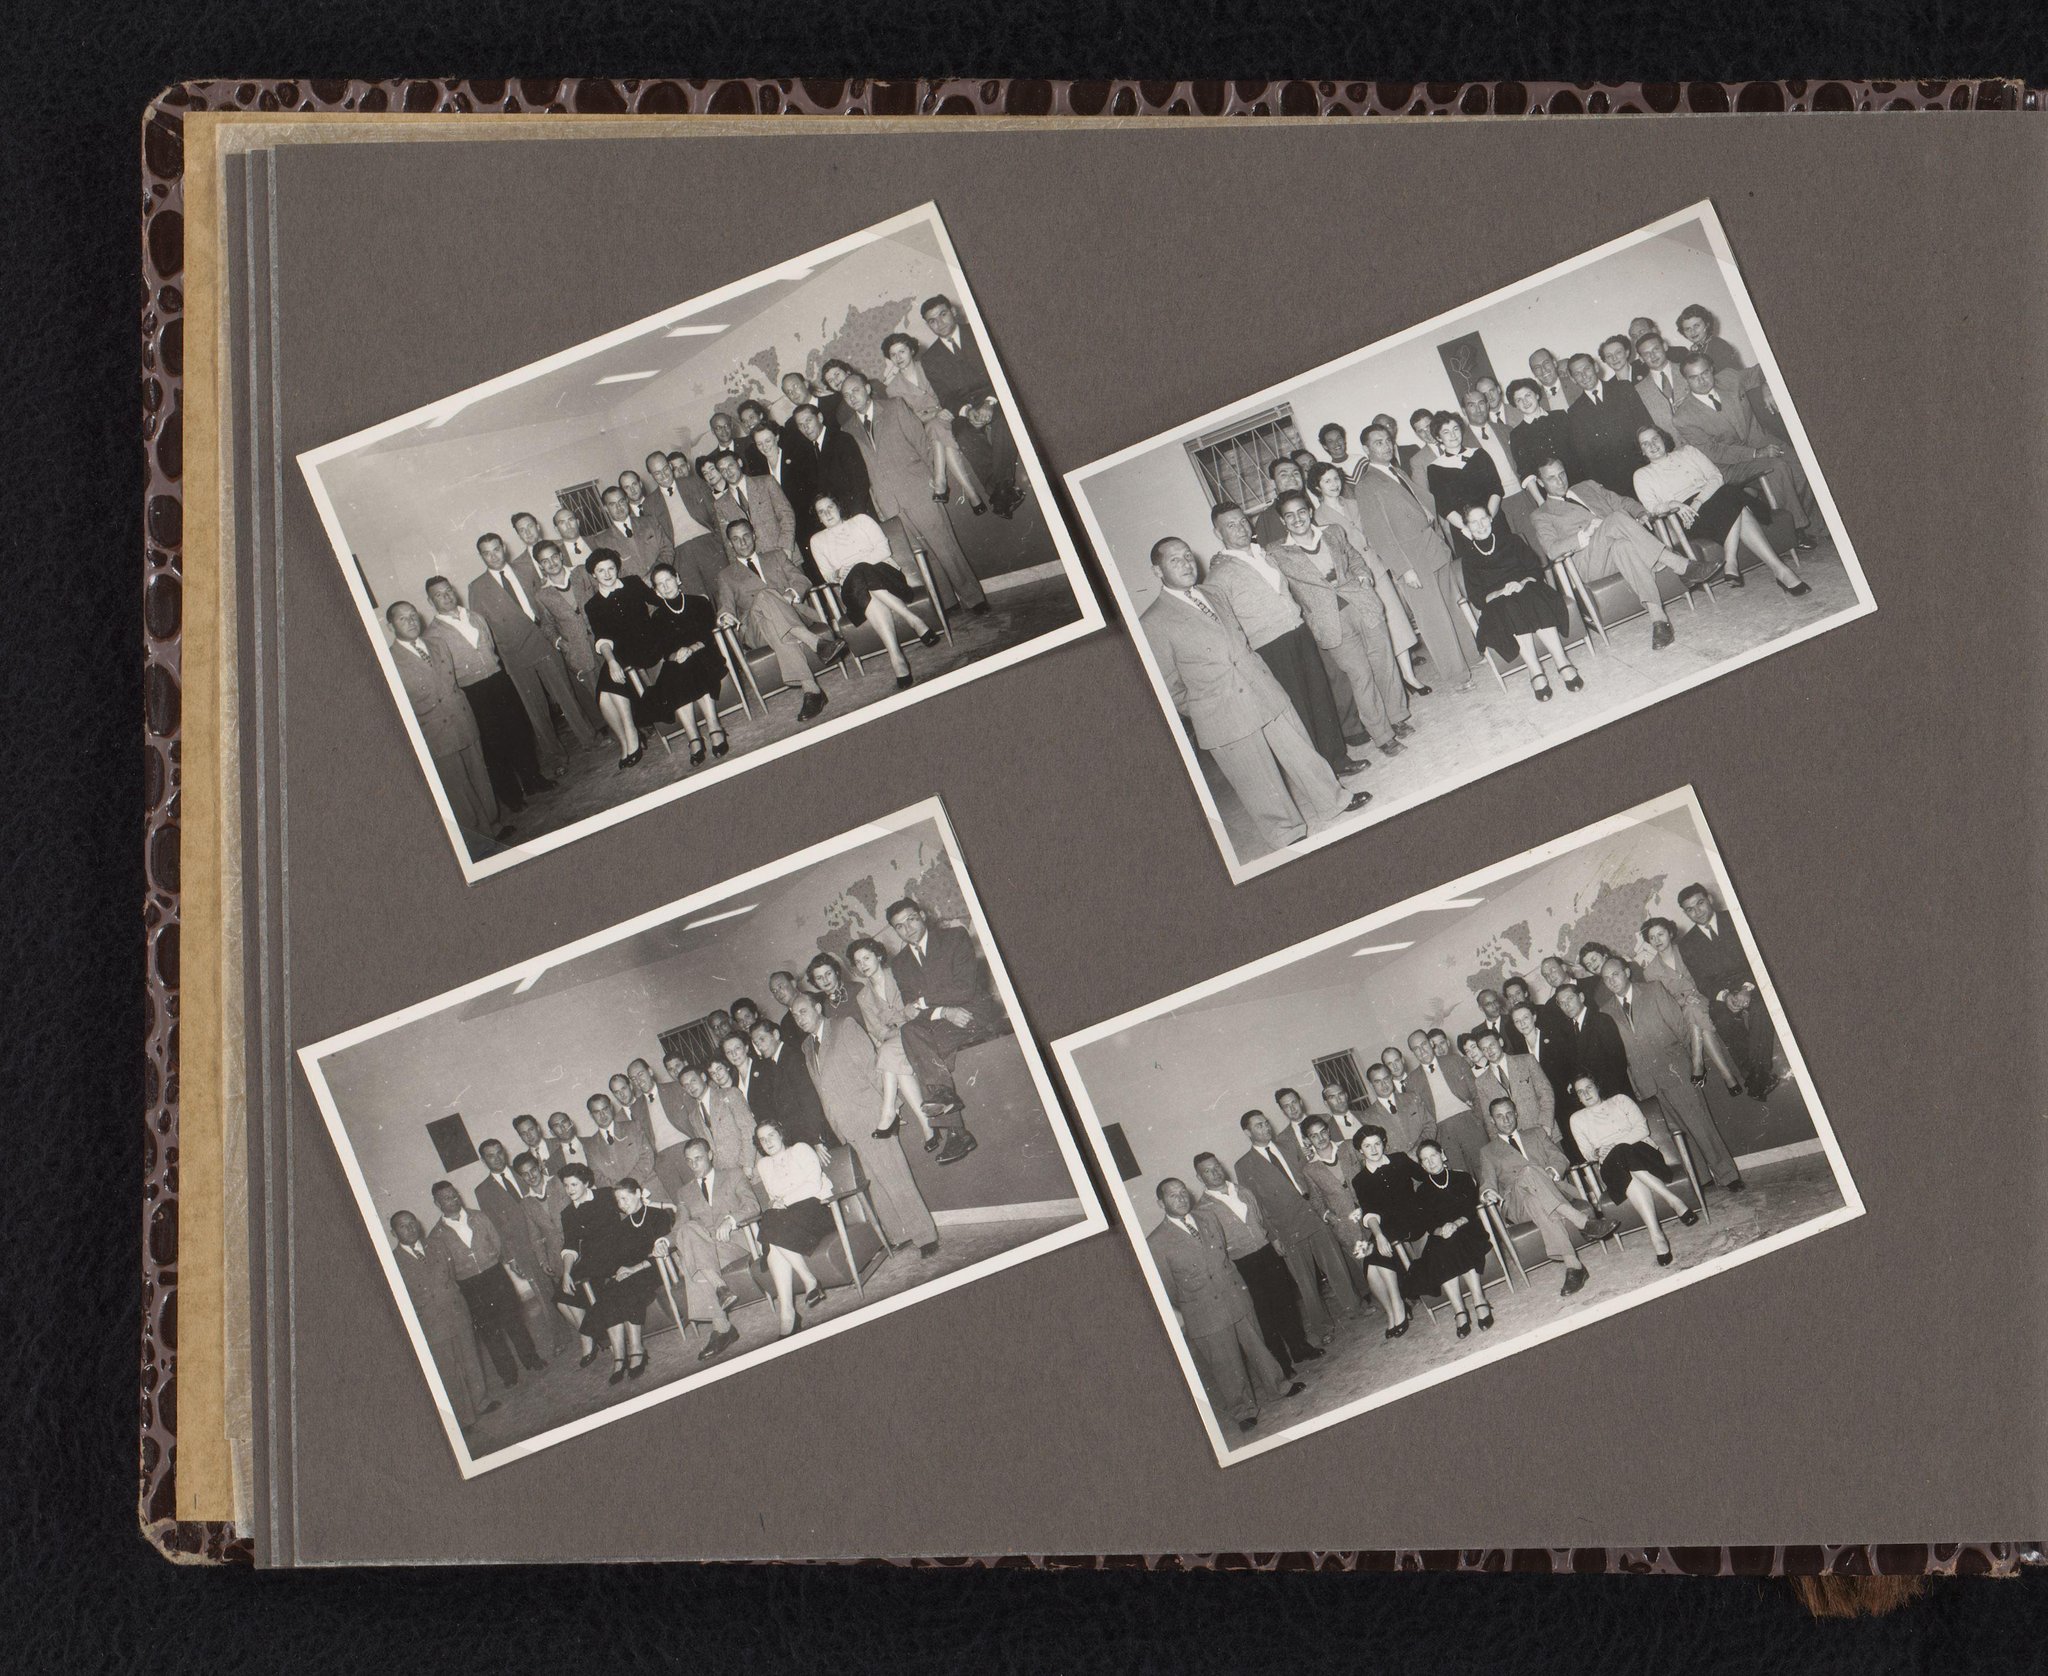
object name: photograph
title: Isabel Wachenheimer met medewerkers van KLM, 1947-1955, Israël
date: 1947-1955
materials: cardboard, photographic support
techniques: gelatin silver print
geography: israel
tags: leiden, isabel wachenheimer-elon, historical persons - bb - woman, anonymous historical persons portrayed in a group, in a group-portrait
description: Blad bevat vier foto's van Isabel Wachenheimer (in KLM-uniform) en onbekende collega's. Uit album half formaat, kunstlederen omslag met koordbinding.